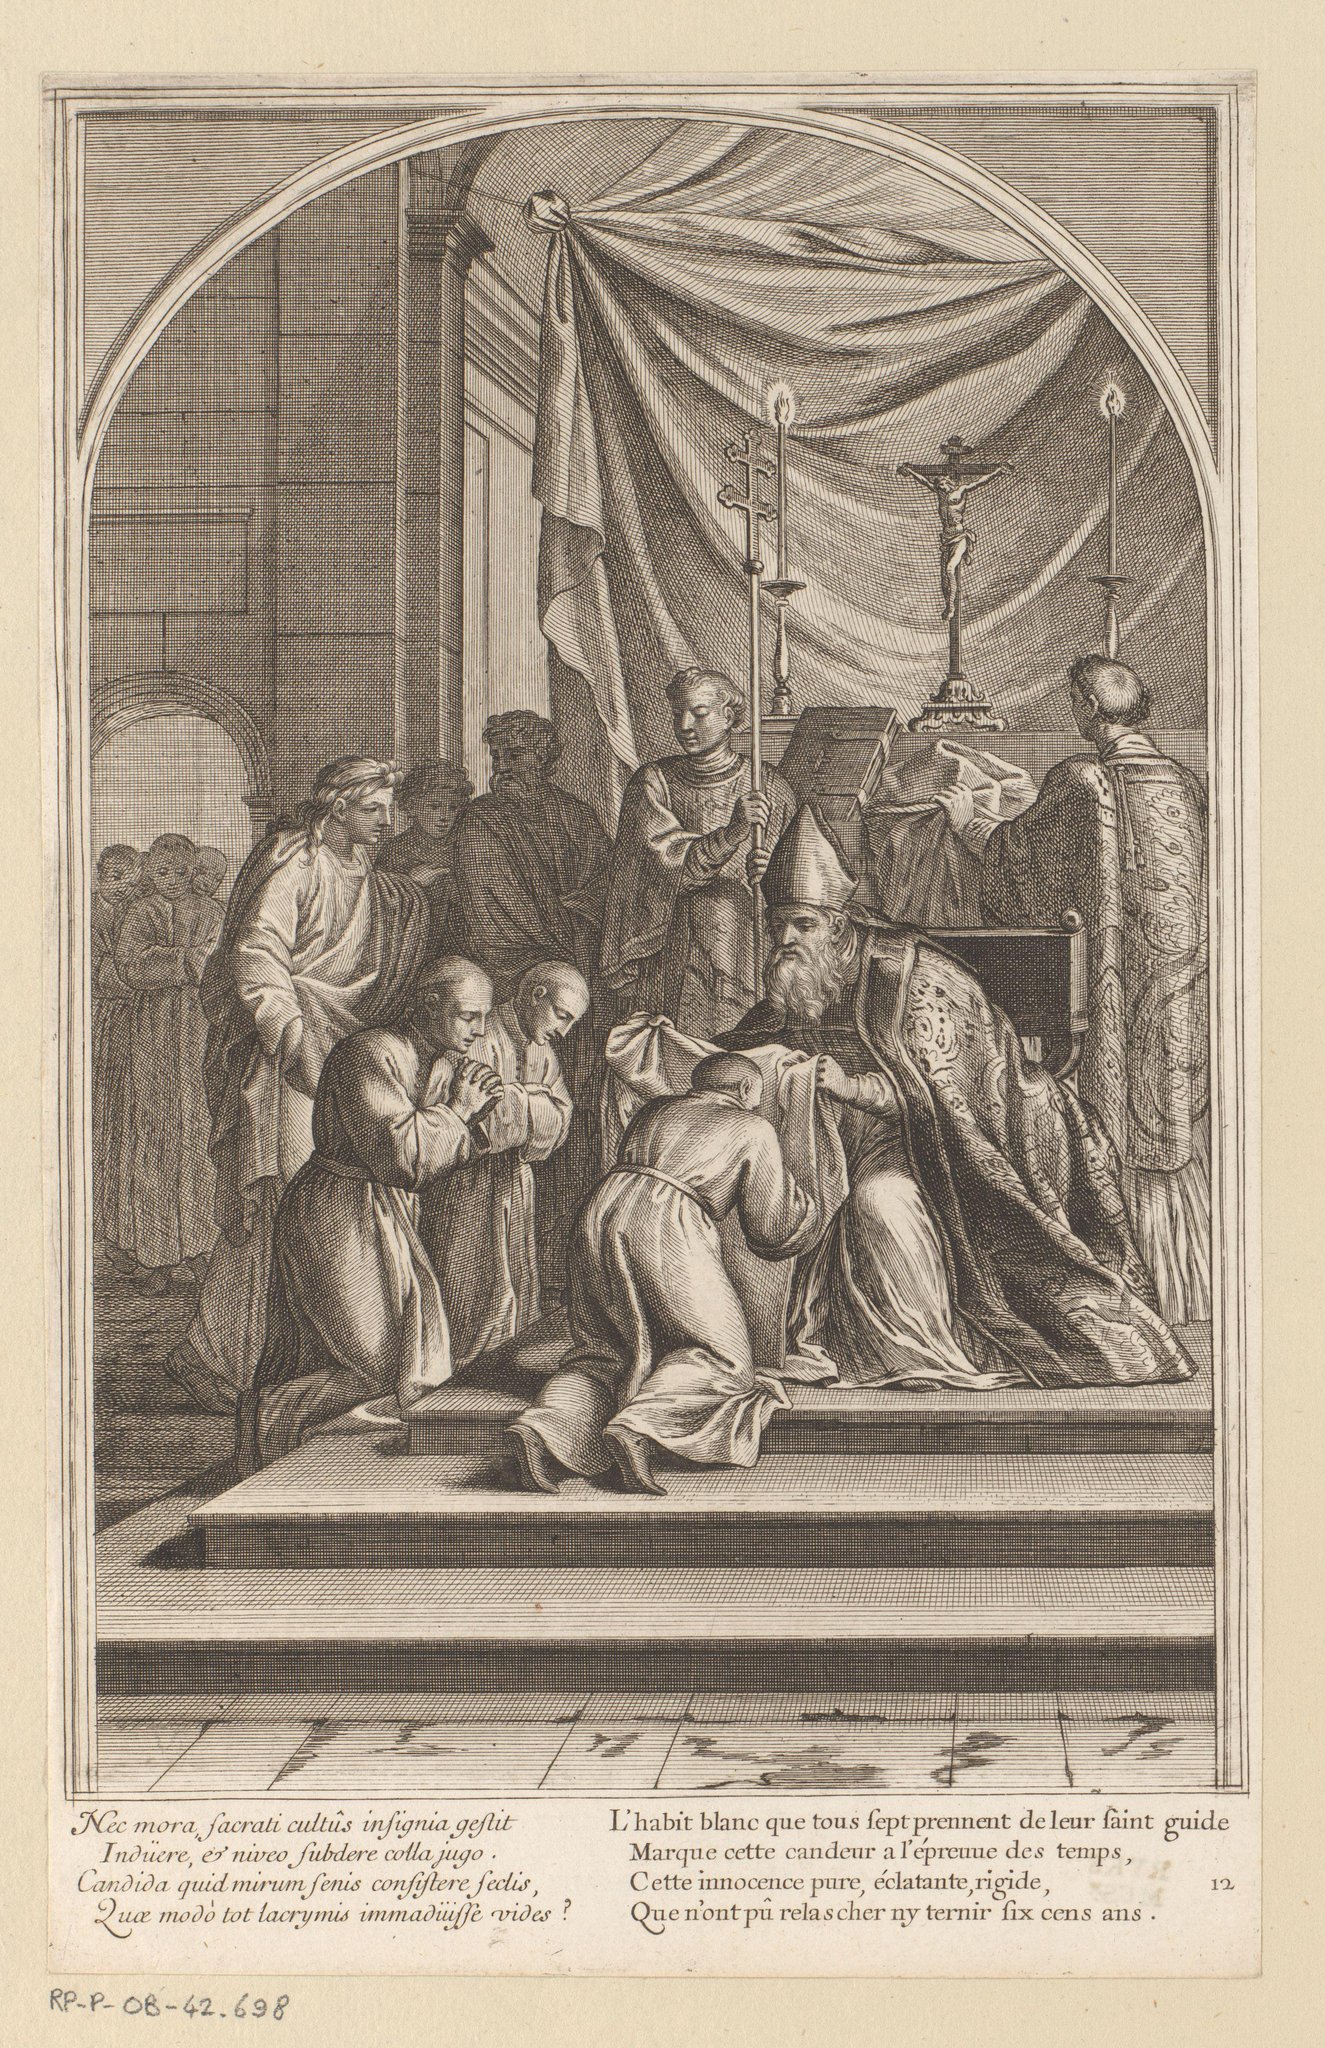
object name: print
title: La vie de St. Bruno (...)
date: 1623-1676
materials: paper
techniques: engraving, etching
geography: paris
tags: the founder of the order of the carthusians, bruno; possible attributes: cross, finger at lips, lily, mitre at his feet, olive-branch, ray of light, skull, (seven) star(s)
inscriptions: collector's mark: Lugt 2165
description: Maakt deel uit van een serie met 24 prenten (inclusief twee titelprenten), naar schilderijen door Lesueur vervaardigd tussen 1645-1648 voor de Chartreuse de Paris. De serie is getiteld: La vie de St. Bruno fondateur de l'Ordre des Chartreux peinte au cloistre de la Chartreuse de Paris par Eustache Le Sueur.